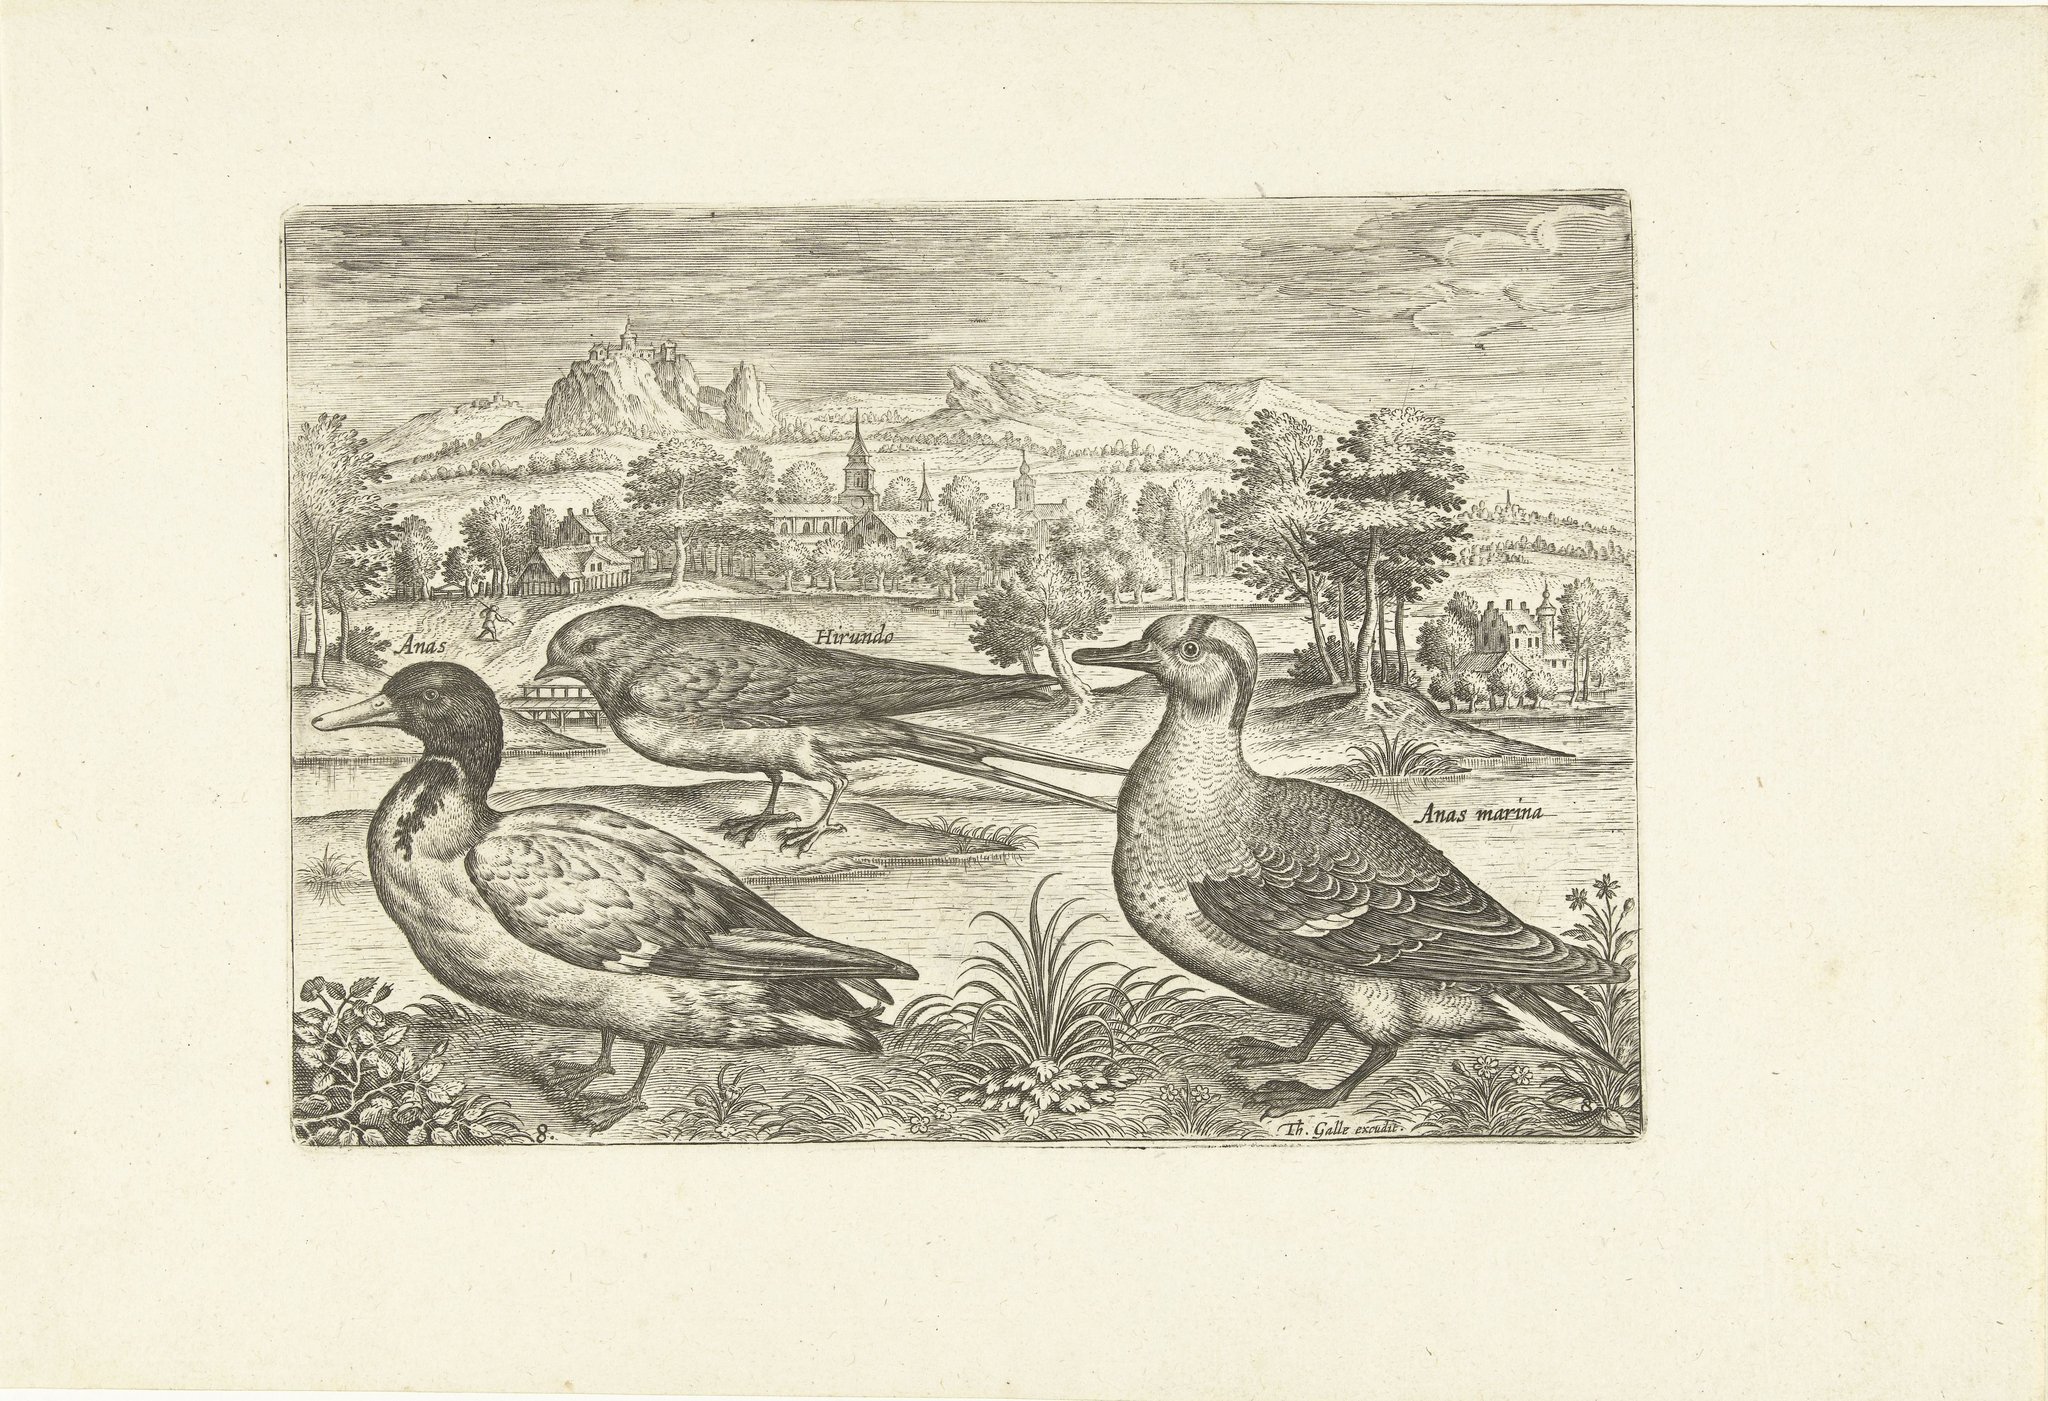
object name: print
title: Enkele vogels in een landschap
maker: adriaen collaert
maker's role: draughtsman, print maker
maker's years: 1560-1618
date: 1598-1618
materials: paper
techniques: engraving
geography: antwerp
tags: river, song-birds: swallow, water-birds: duck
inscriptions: collector's mark: Lugt 2228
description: Twee wilde eenden en een zwaluw in een rivierlandschap. Op de achtergrond een kerk. De prent maakt deel uit van een serie met vogels als onderwerp.